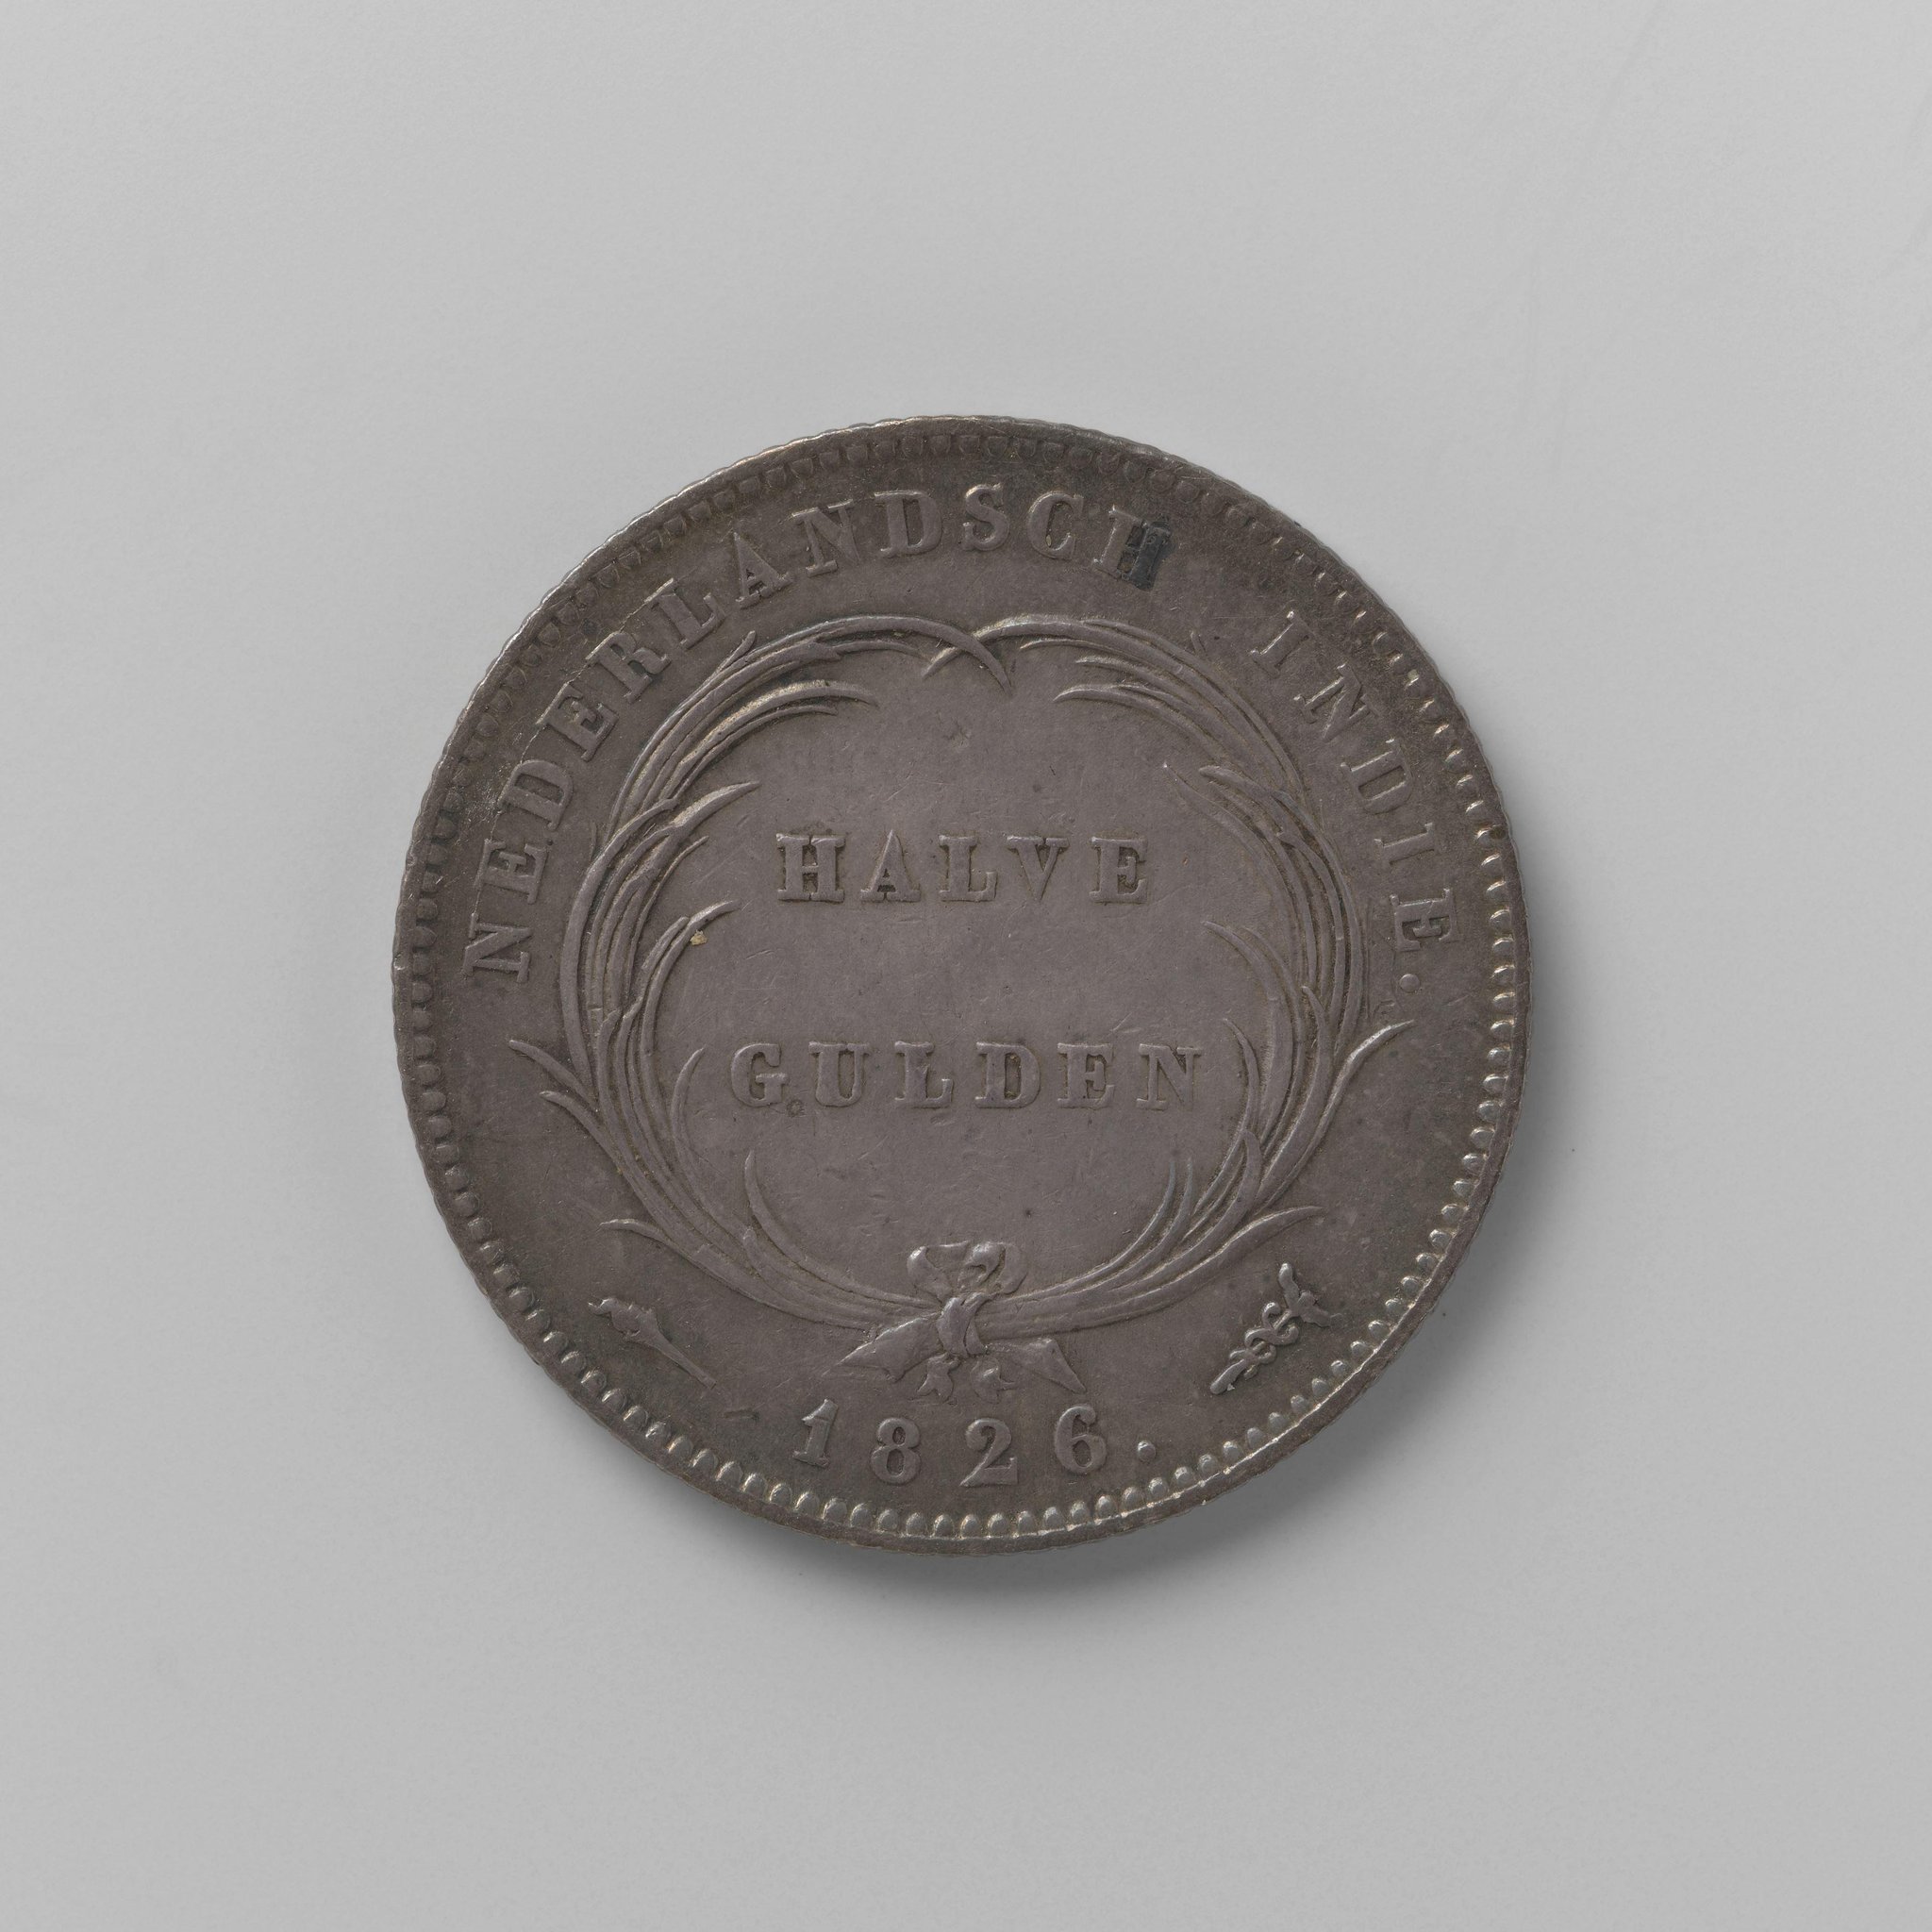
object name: coin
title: Nederlands Indië, ½ gulden, 1826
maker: william i of the netherlands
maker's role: koning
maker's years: 1772-1843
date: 1826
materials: silver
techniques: striking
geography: utrecht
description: Zilveren munt. Voorzijde: borstbeeld naar rechts. Keerzijde: tussen twee samengebonden palmtakken waarde-aanduiding. Jaartal onderaan. Kartelrand